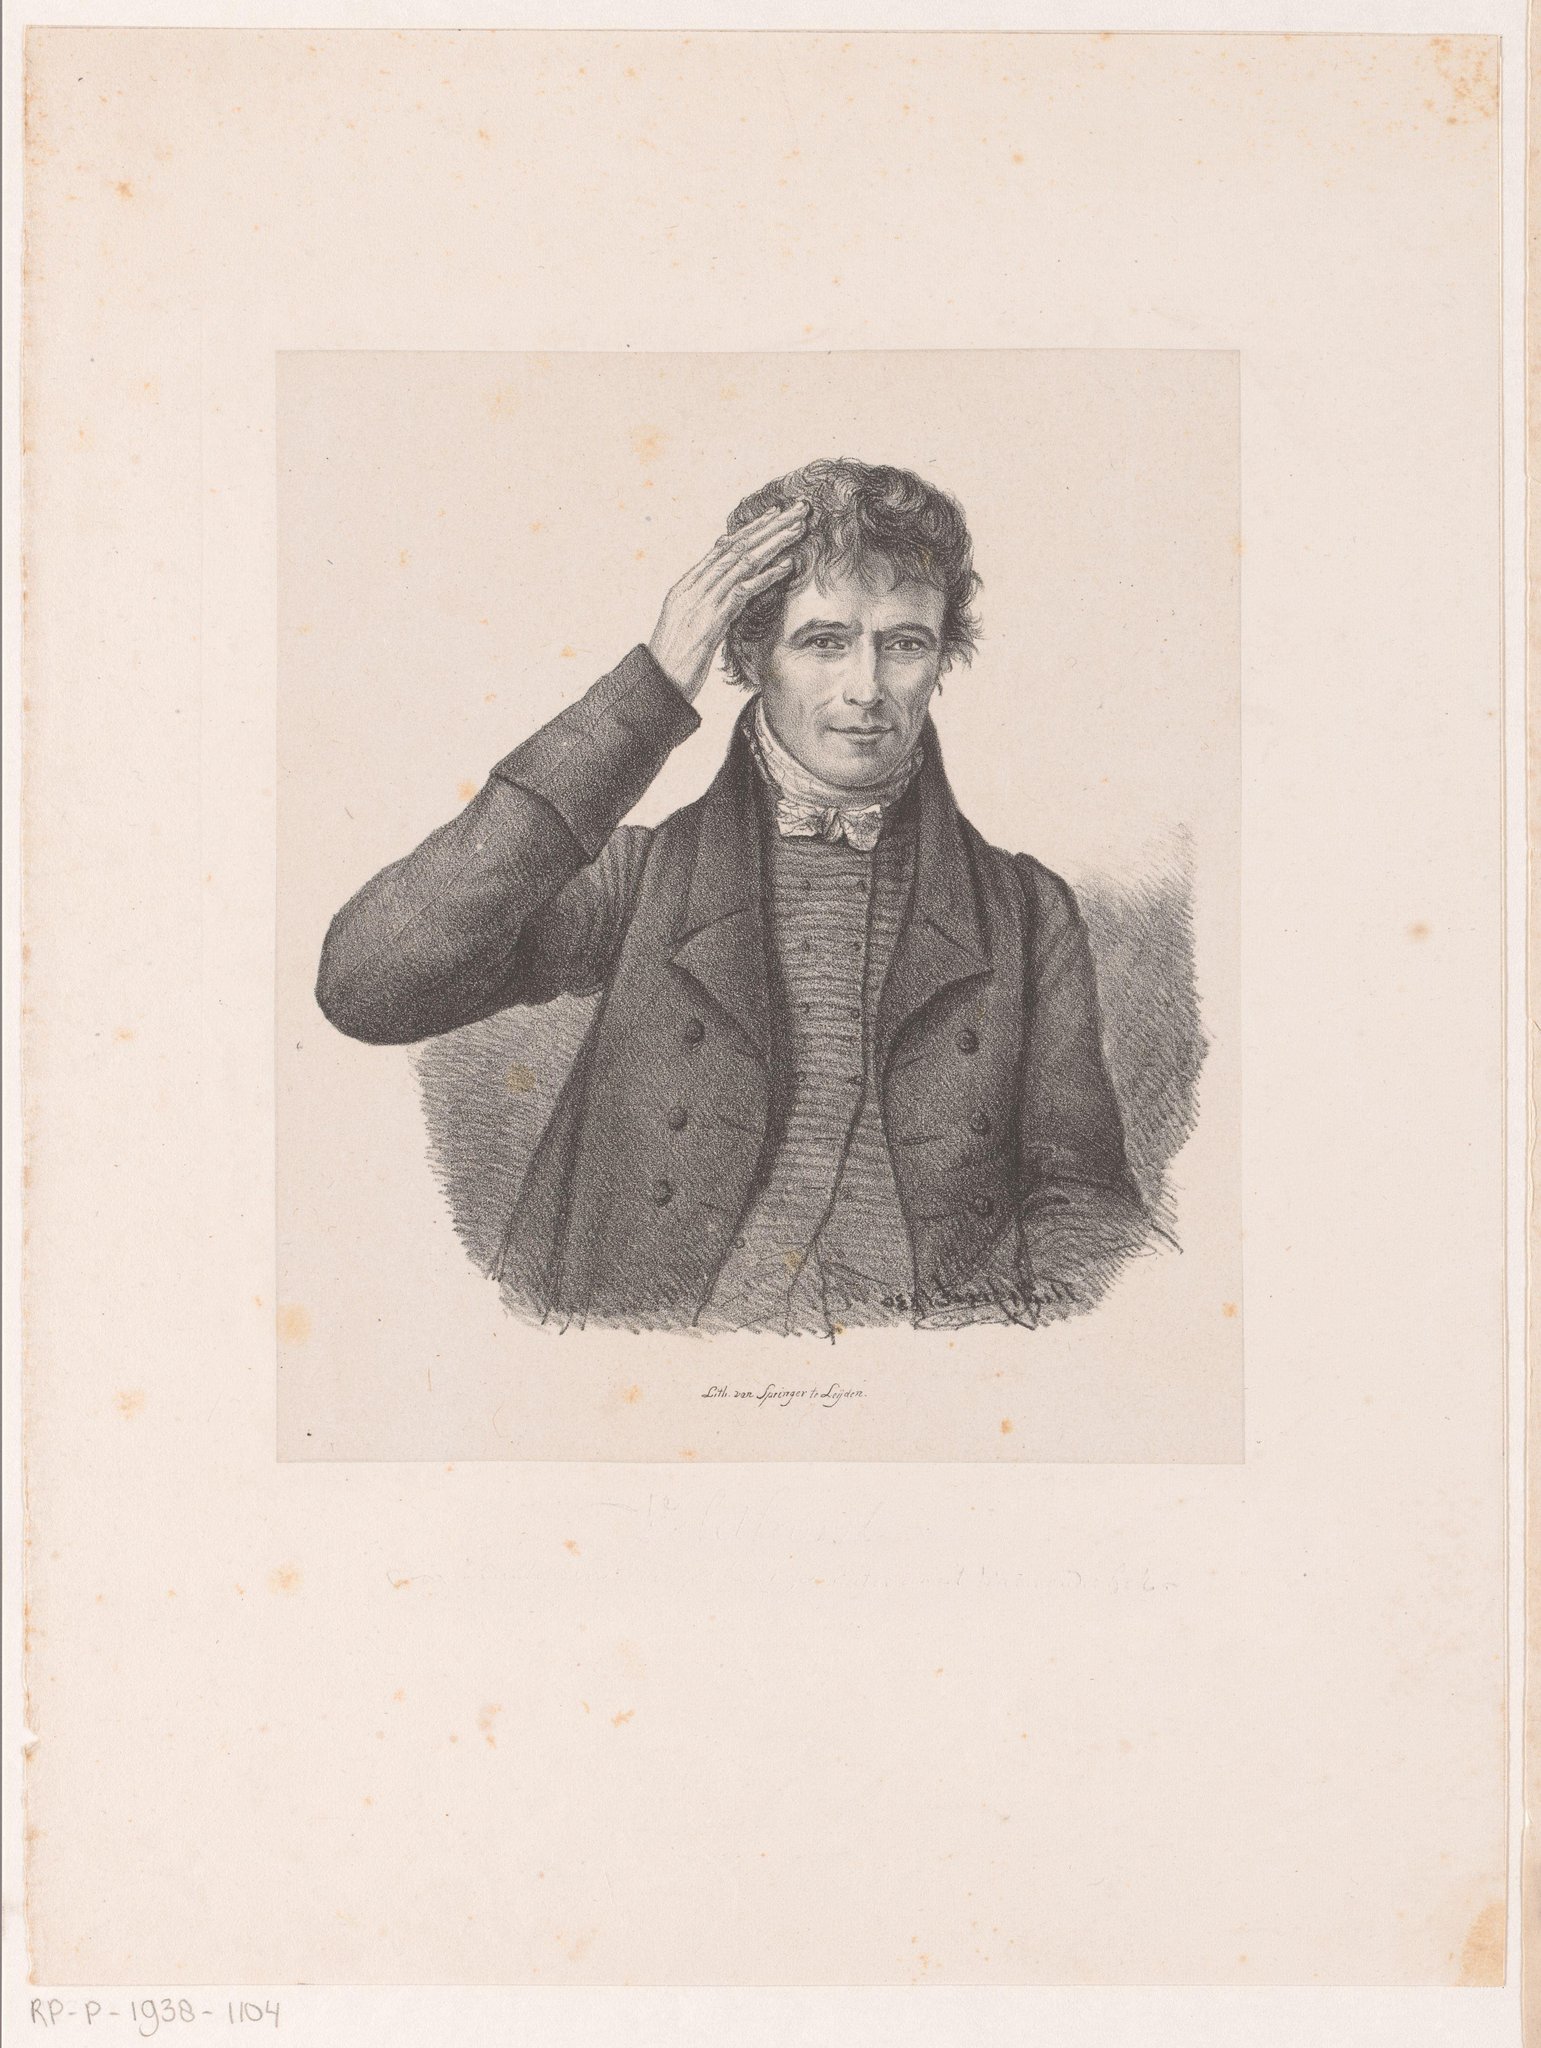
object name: print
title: Portret van D.W. Veldhorst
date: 1830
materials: paper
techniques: lithograph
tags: historical persons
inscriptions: collector's mark: Lugt 2760, collector's mark: Lugt 2228